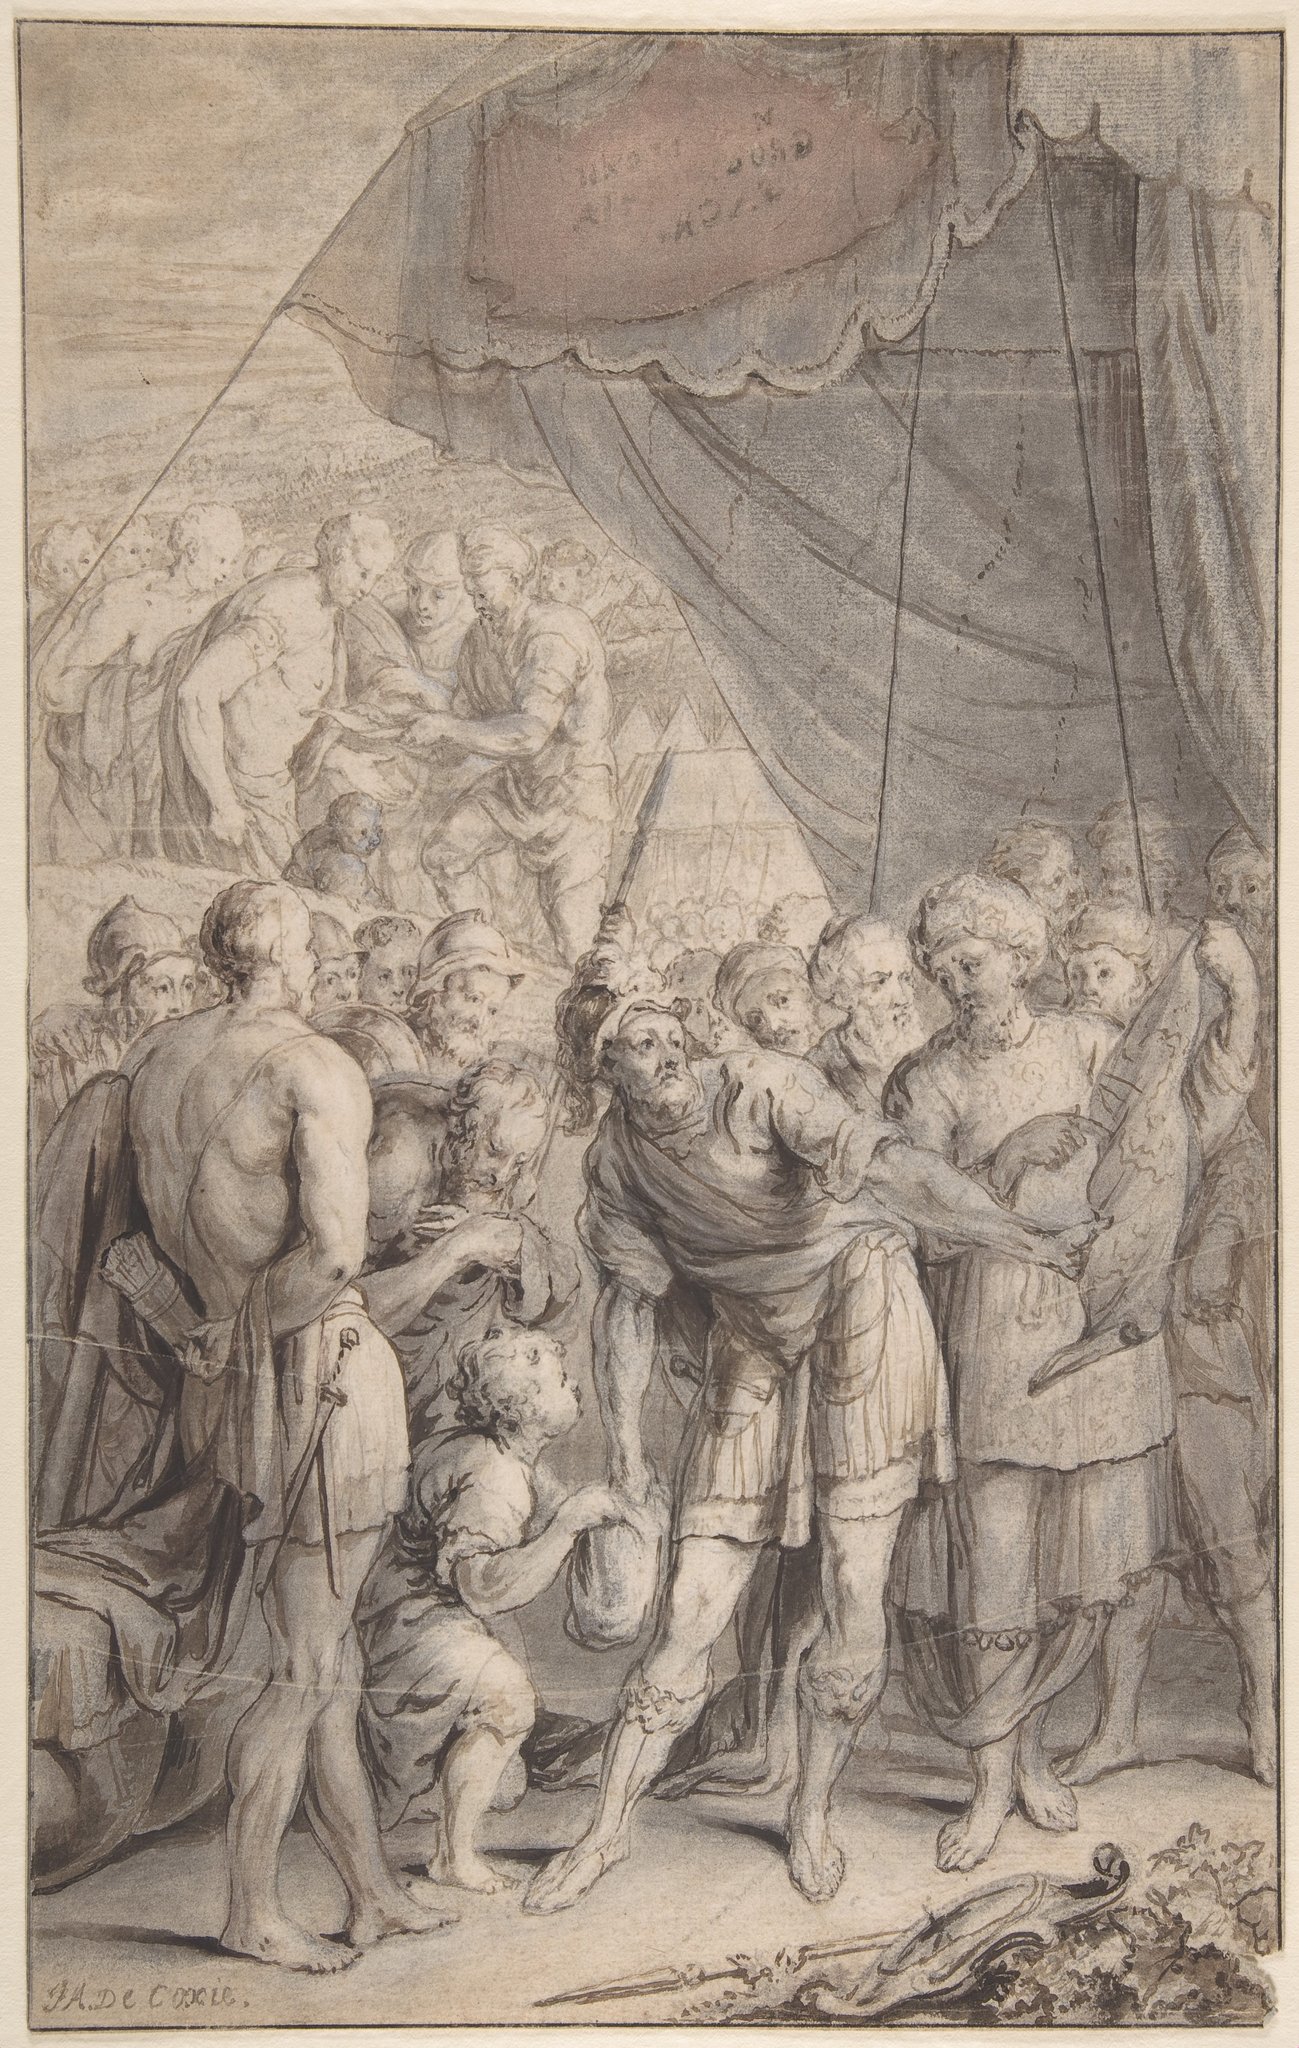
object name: drawing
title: Design for a Title Page: A General and His Army Looking at a Map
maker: jan antoine coxie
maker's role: artist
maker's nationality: flemish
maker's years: 1650-1720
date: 1667-1700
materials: chalk, gouache, ink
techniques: brush, heightening, incising, pen, wash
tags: soldiers,spears,swords,men